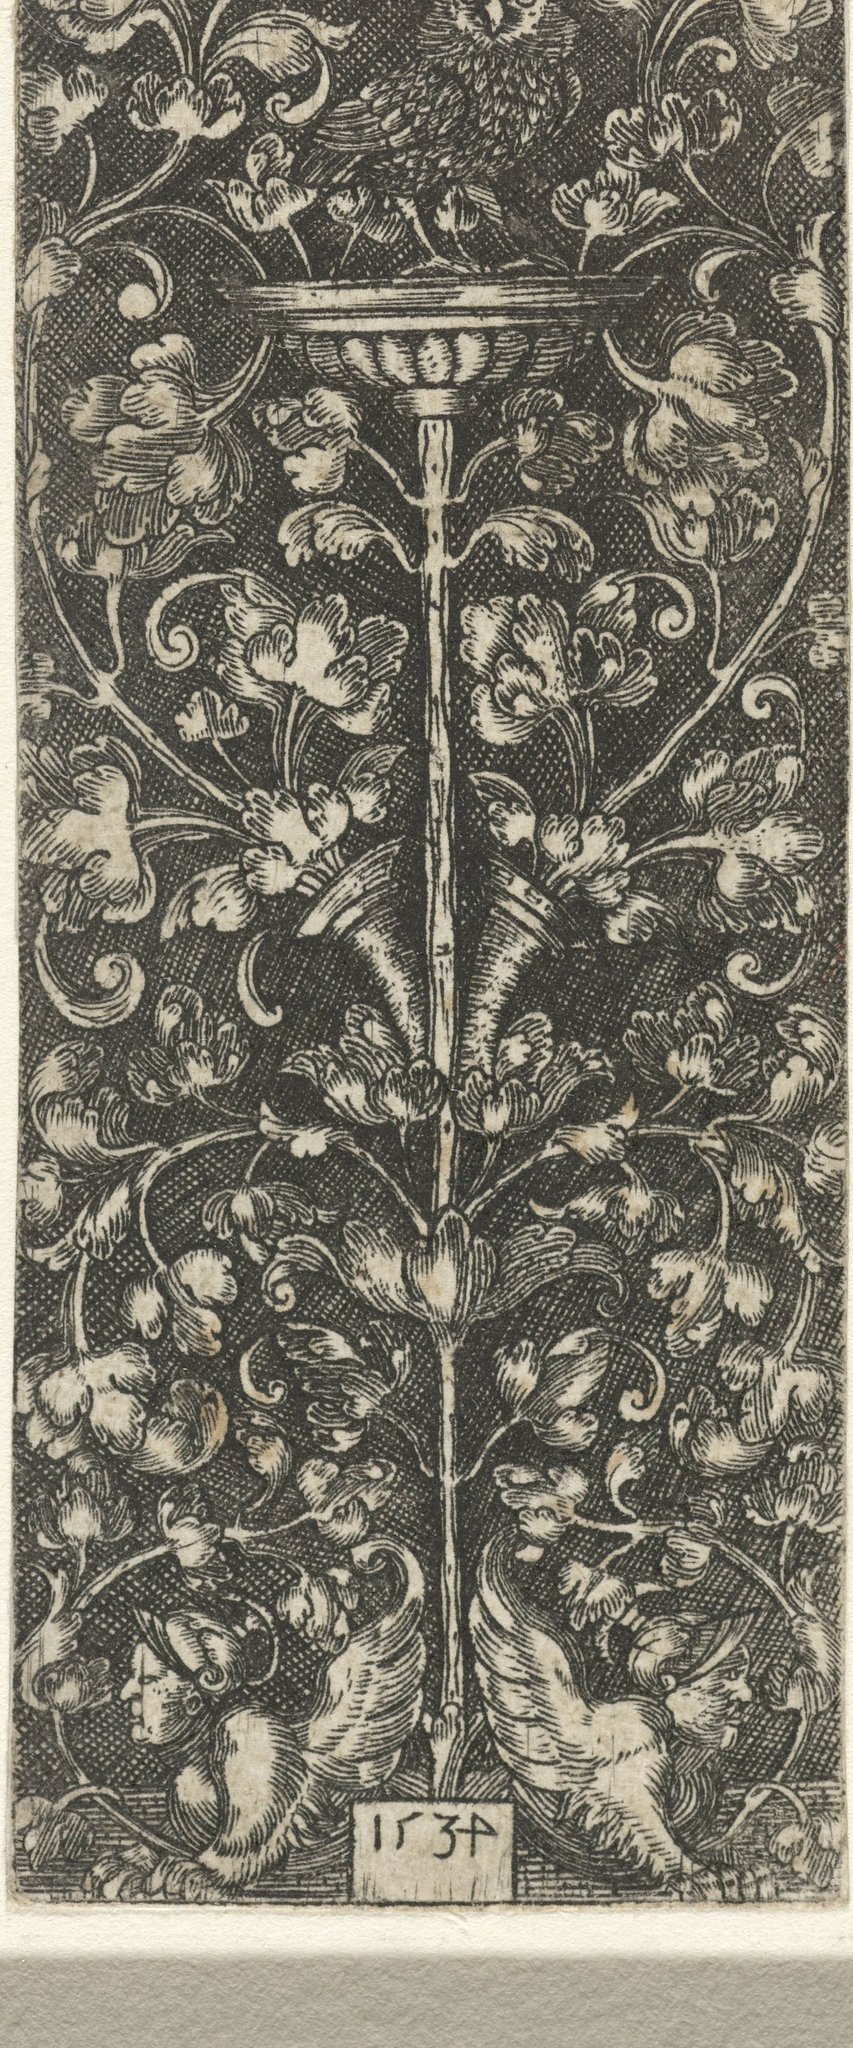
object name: print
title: Vlakdecoratie met bladranken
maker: Anonymous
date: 1534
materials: paper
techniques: engraving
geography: germany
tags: sphinx (lion/woman); 'sfinge' (ripa), owls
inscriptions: collector's mark: Lugt 240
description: Op de rechte stengel in het midden rust een plateau waarop een uil zit. De voet van de stengel wordt geflankeerd door twee sfinxen zonder achterlijven. Gearceerde achtergrond.